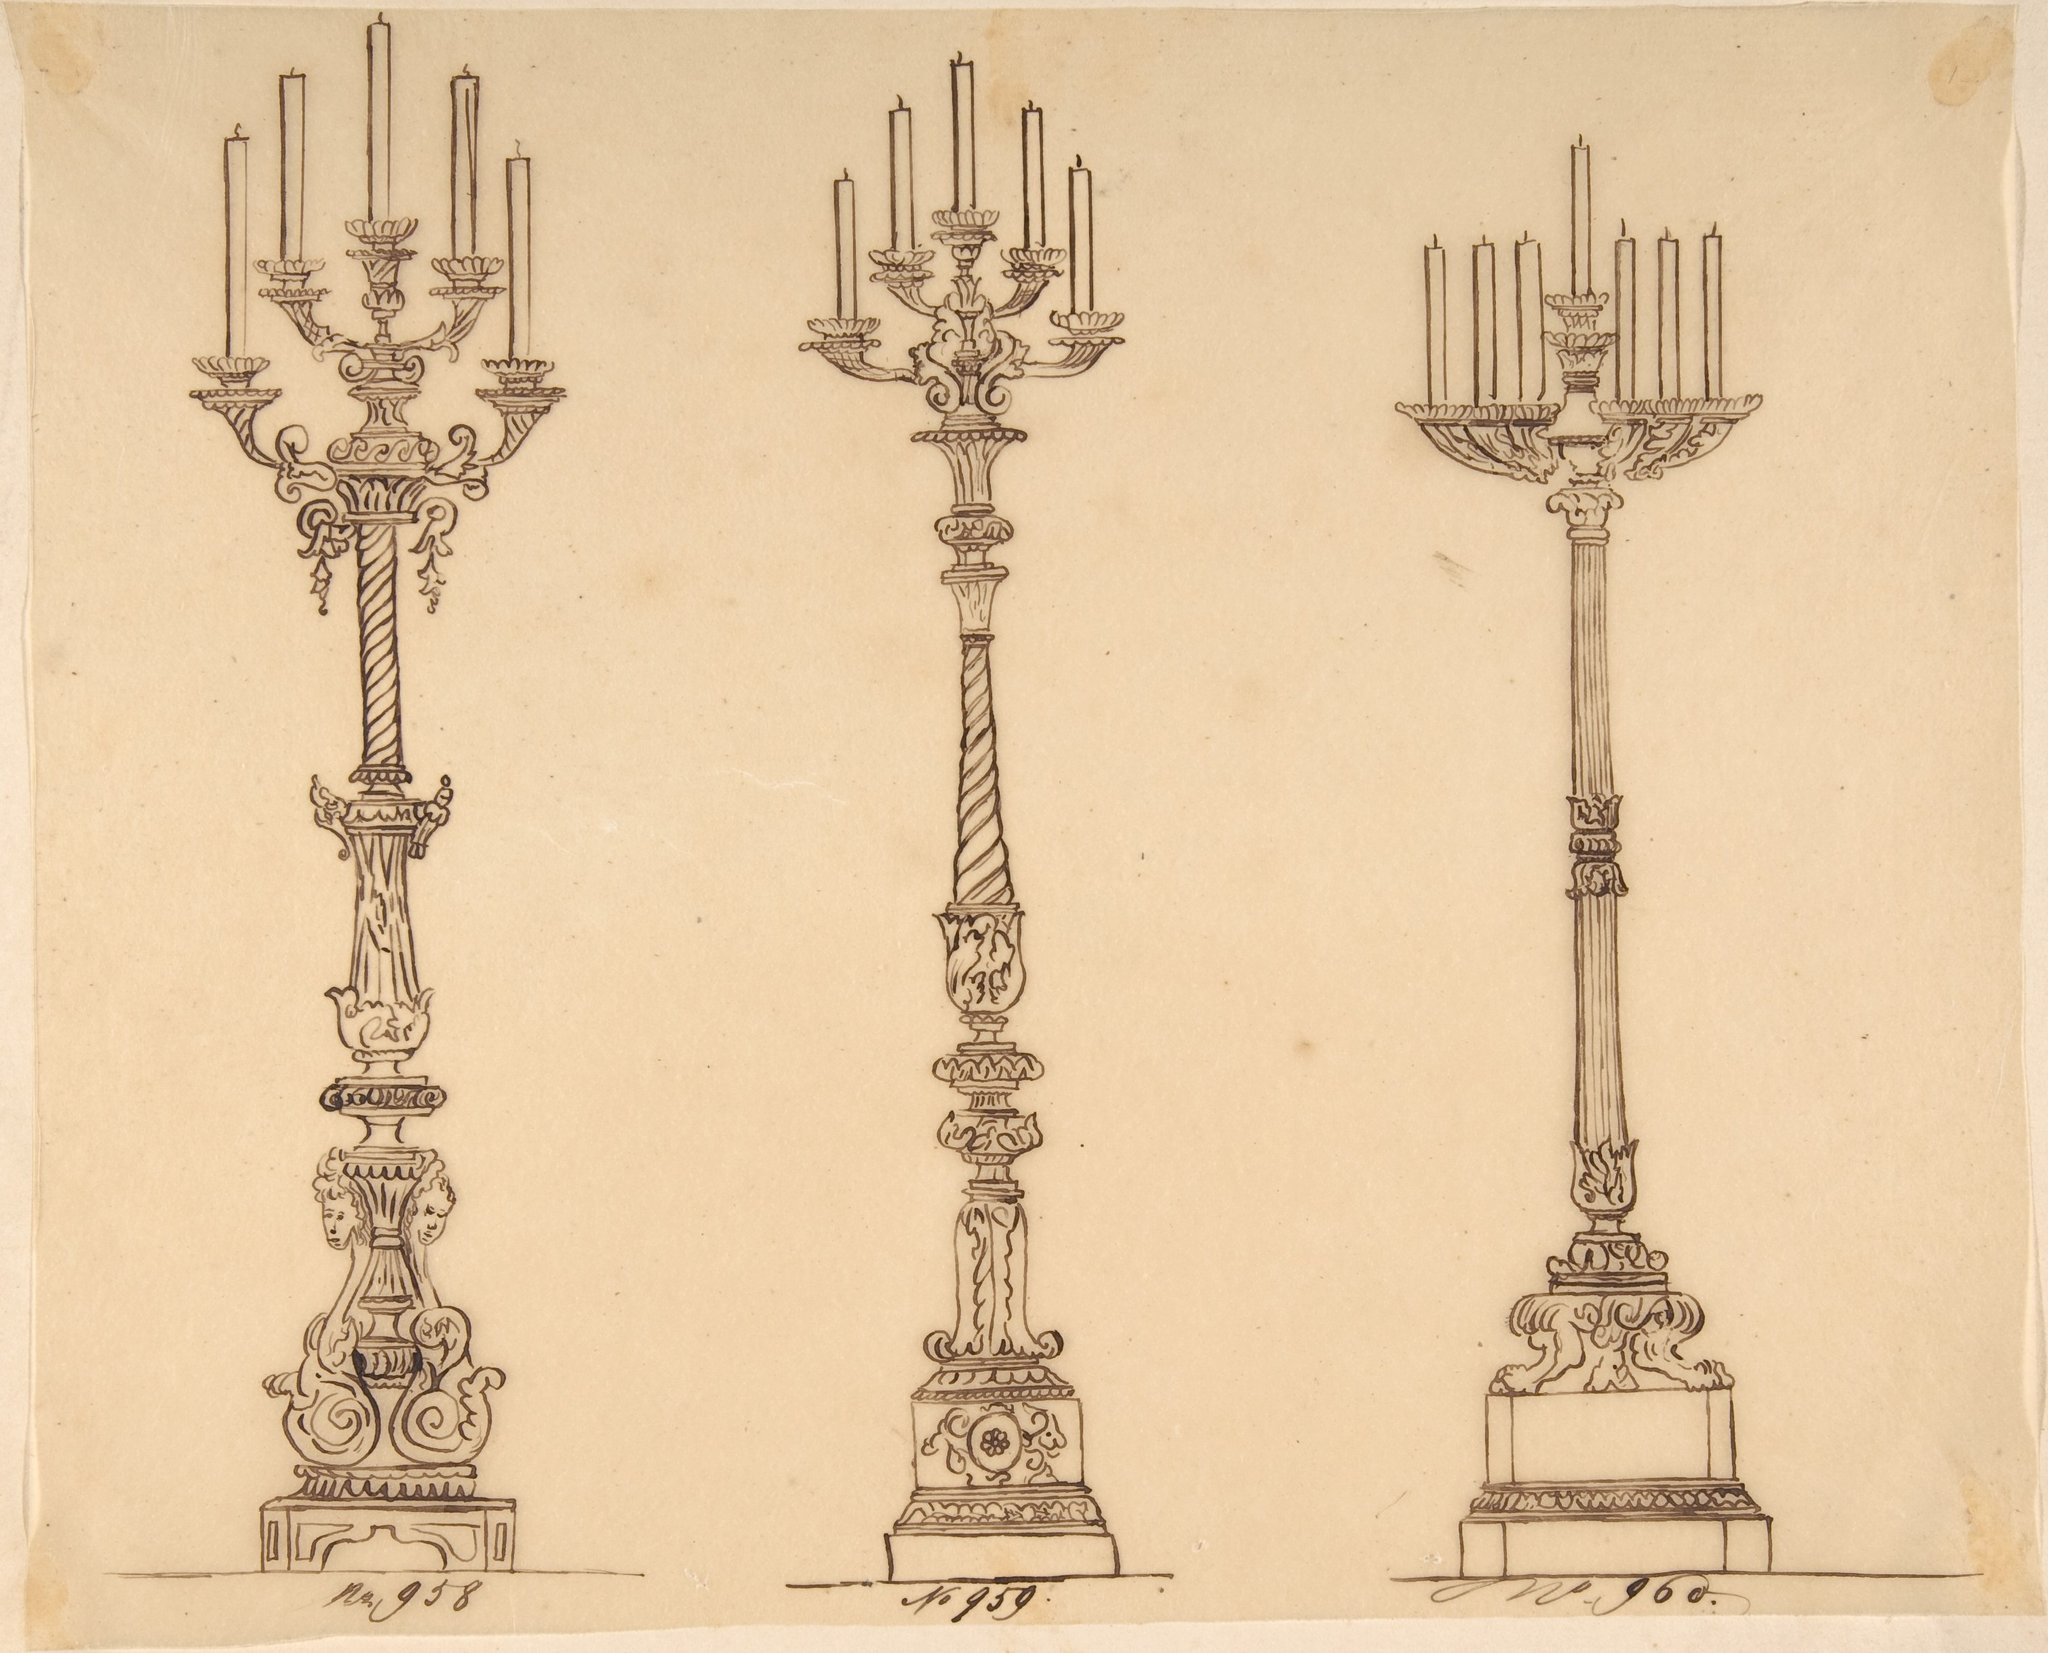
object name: drawing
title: Designs for Three Candelabras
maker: anonymous, french, 19th century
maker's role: artist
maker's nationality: french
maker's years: 1800-1900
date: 1801-1900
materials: ink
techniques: pen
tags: candelabra